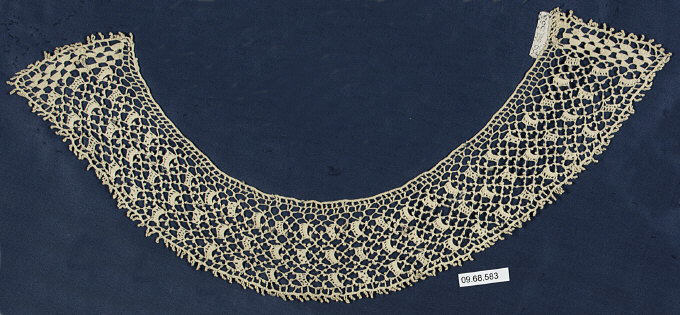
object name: collar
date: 1801-1900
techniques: crochet